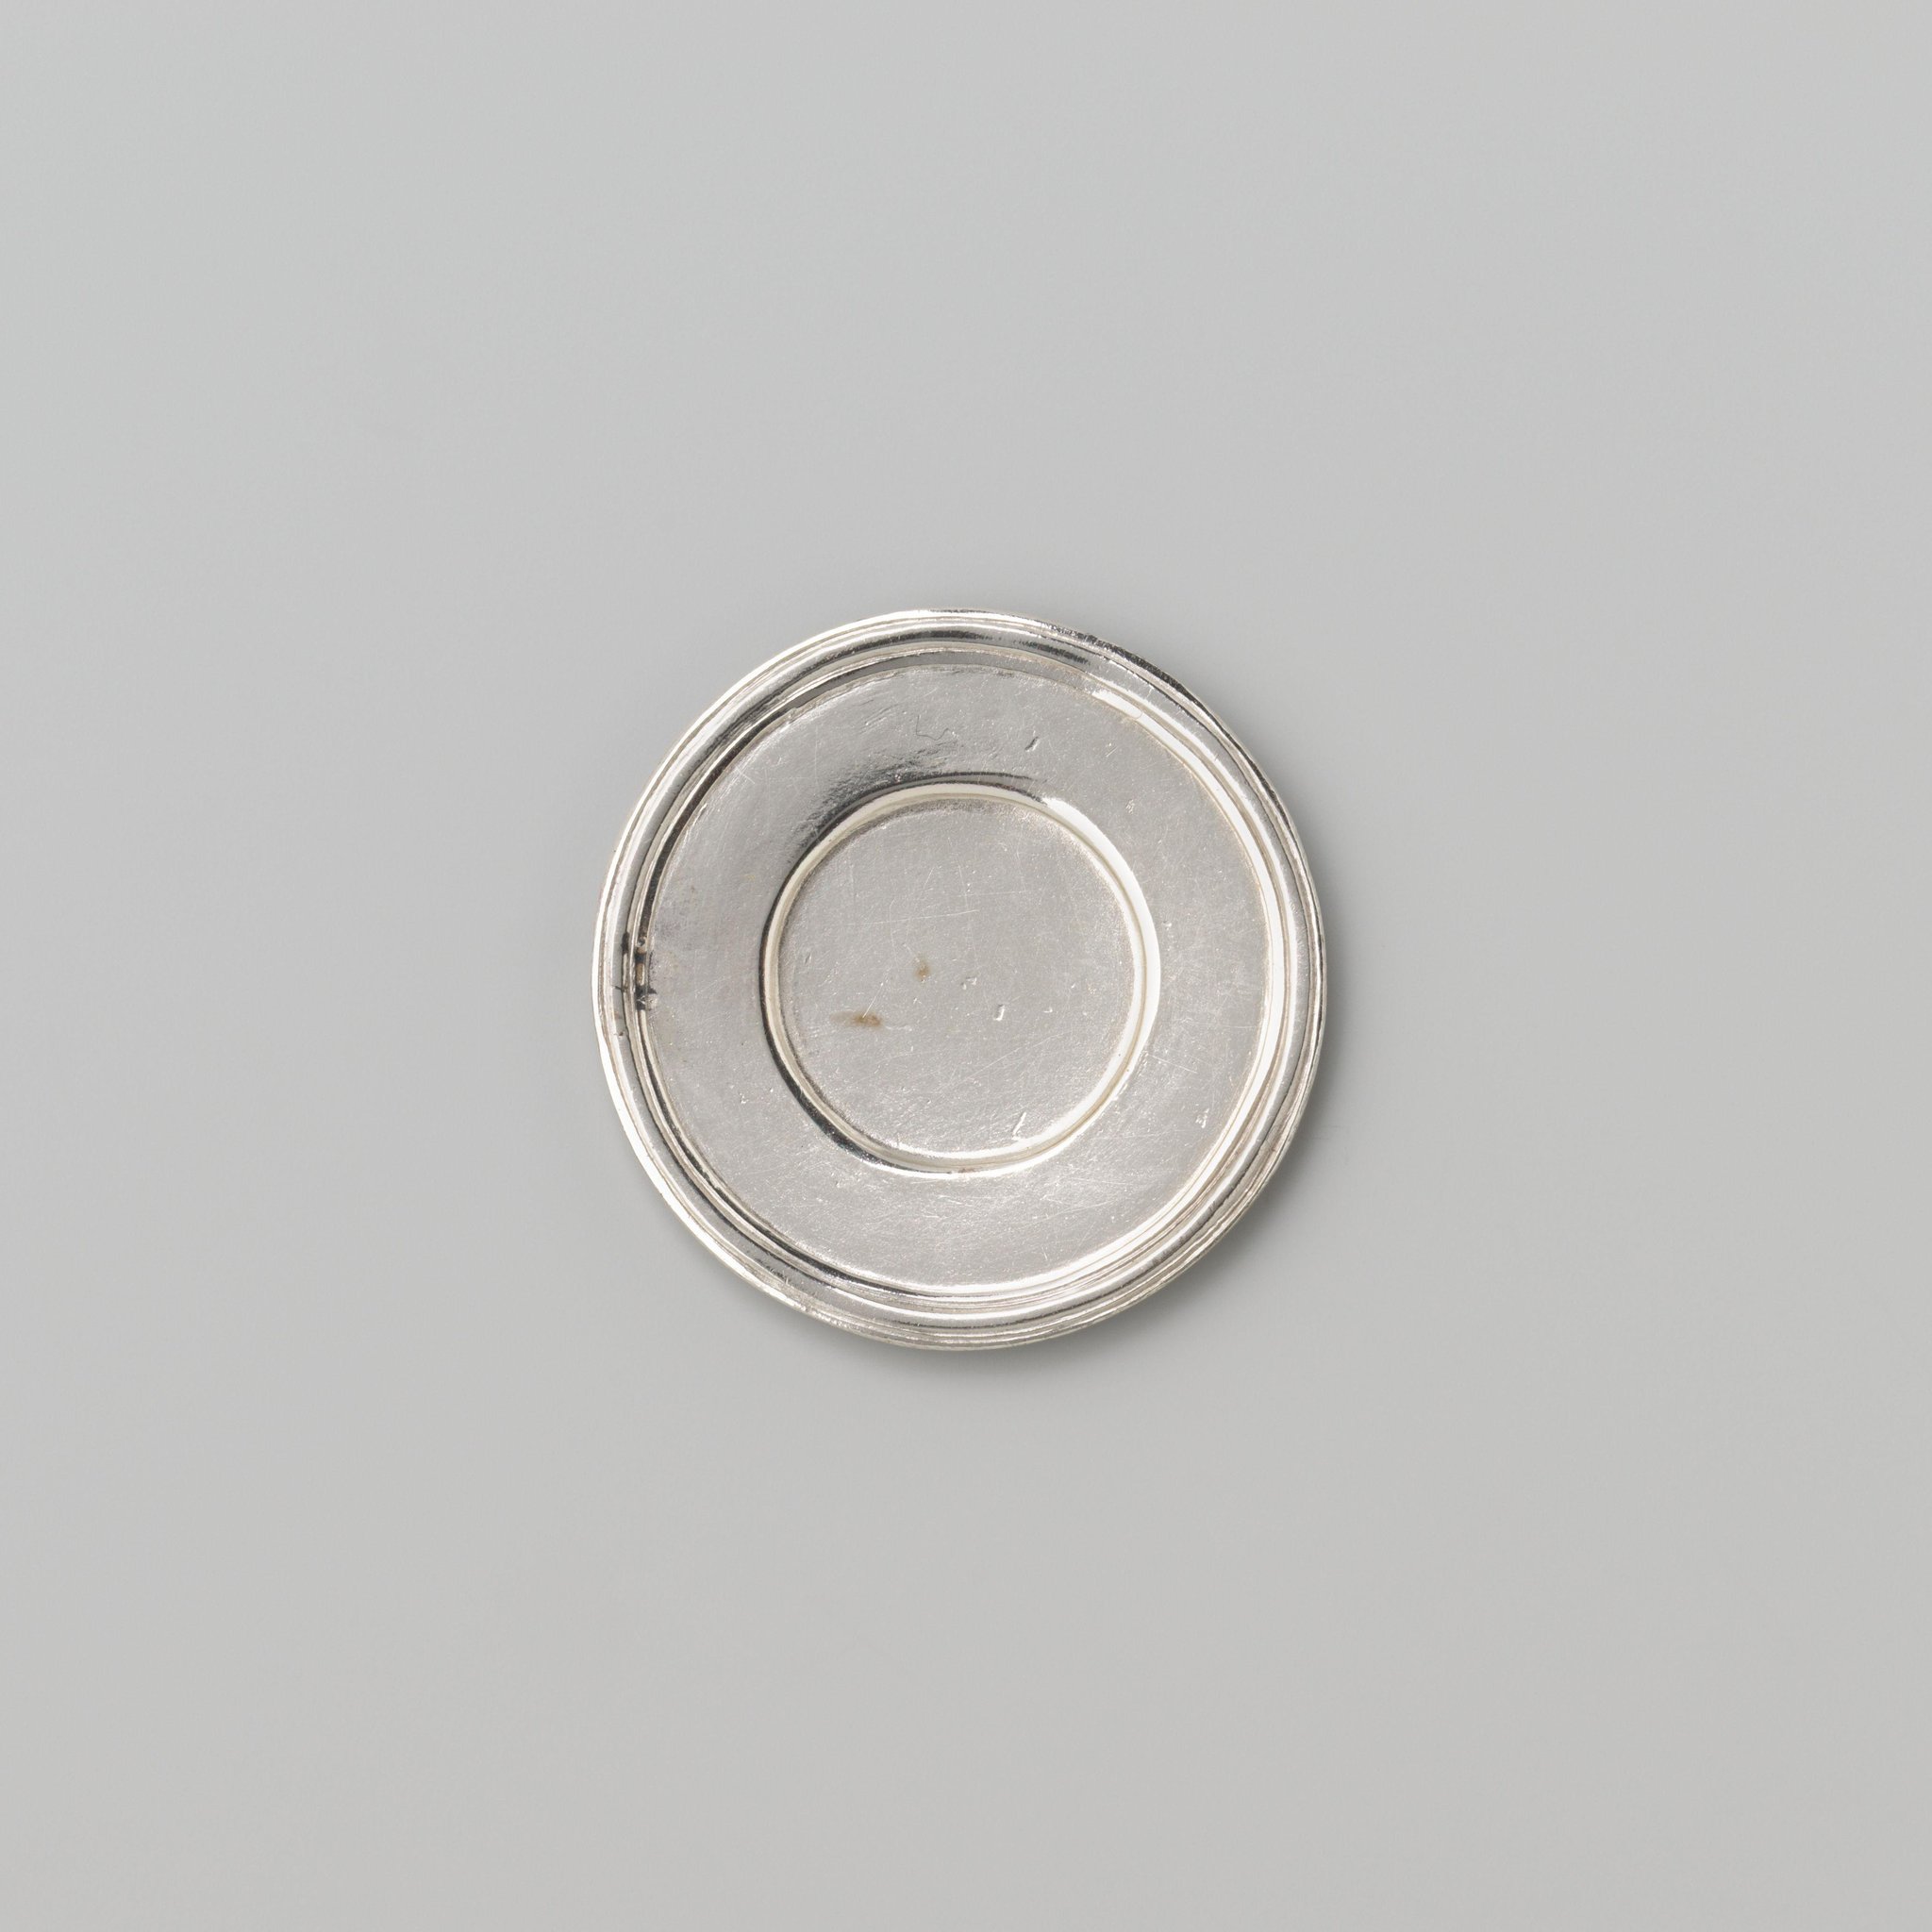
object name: miniature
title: Zilverkleurige schoteltje met brede platte geprofileerde rand.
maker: Anonymous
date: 1700-1710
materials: copper alloy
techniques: silvering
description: Zilverkleurige schotel met brede, platte geprofileerde rand.